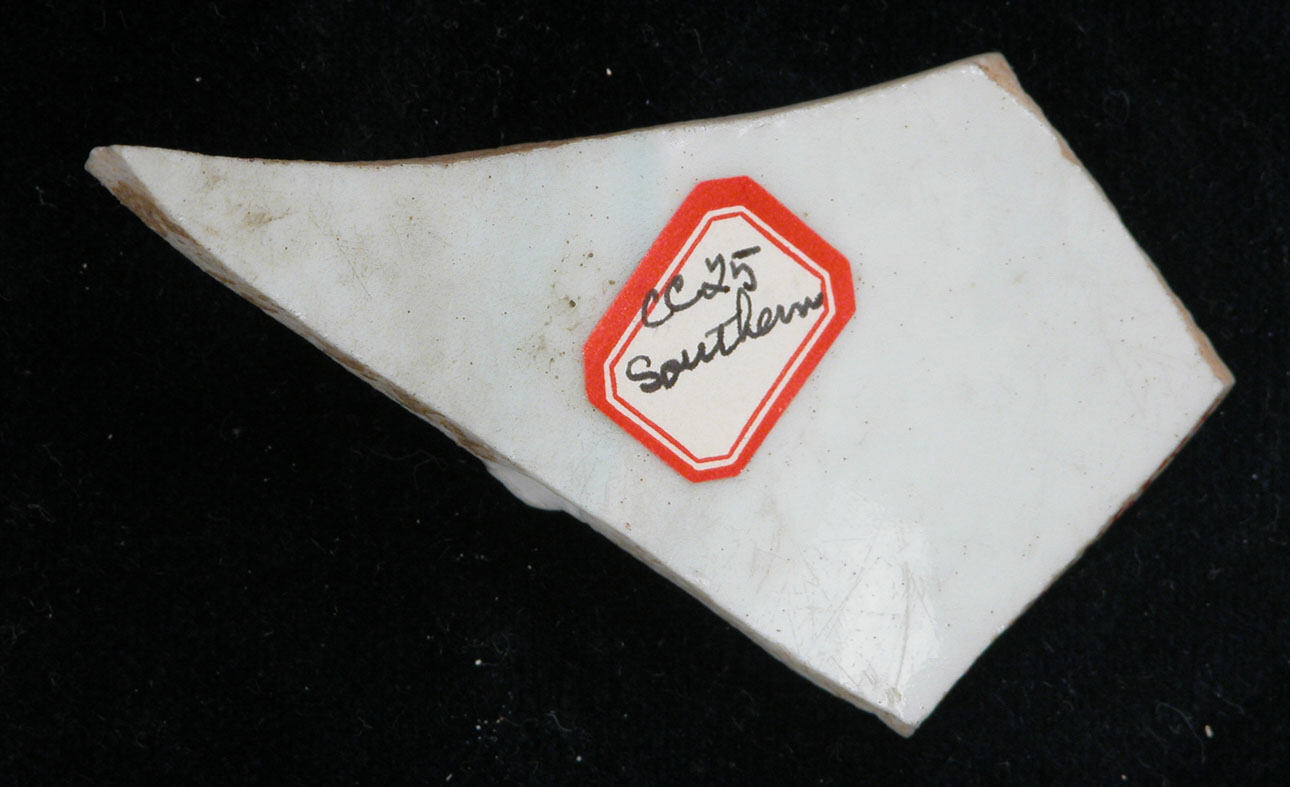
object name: fragment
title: Fragment of a Bowl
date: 801-1000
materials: porcelain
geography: china